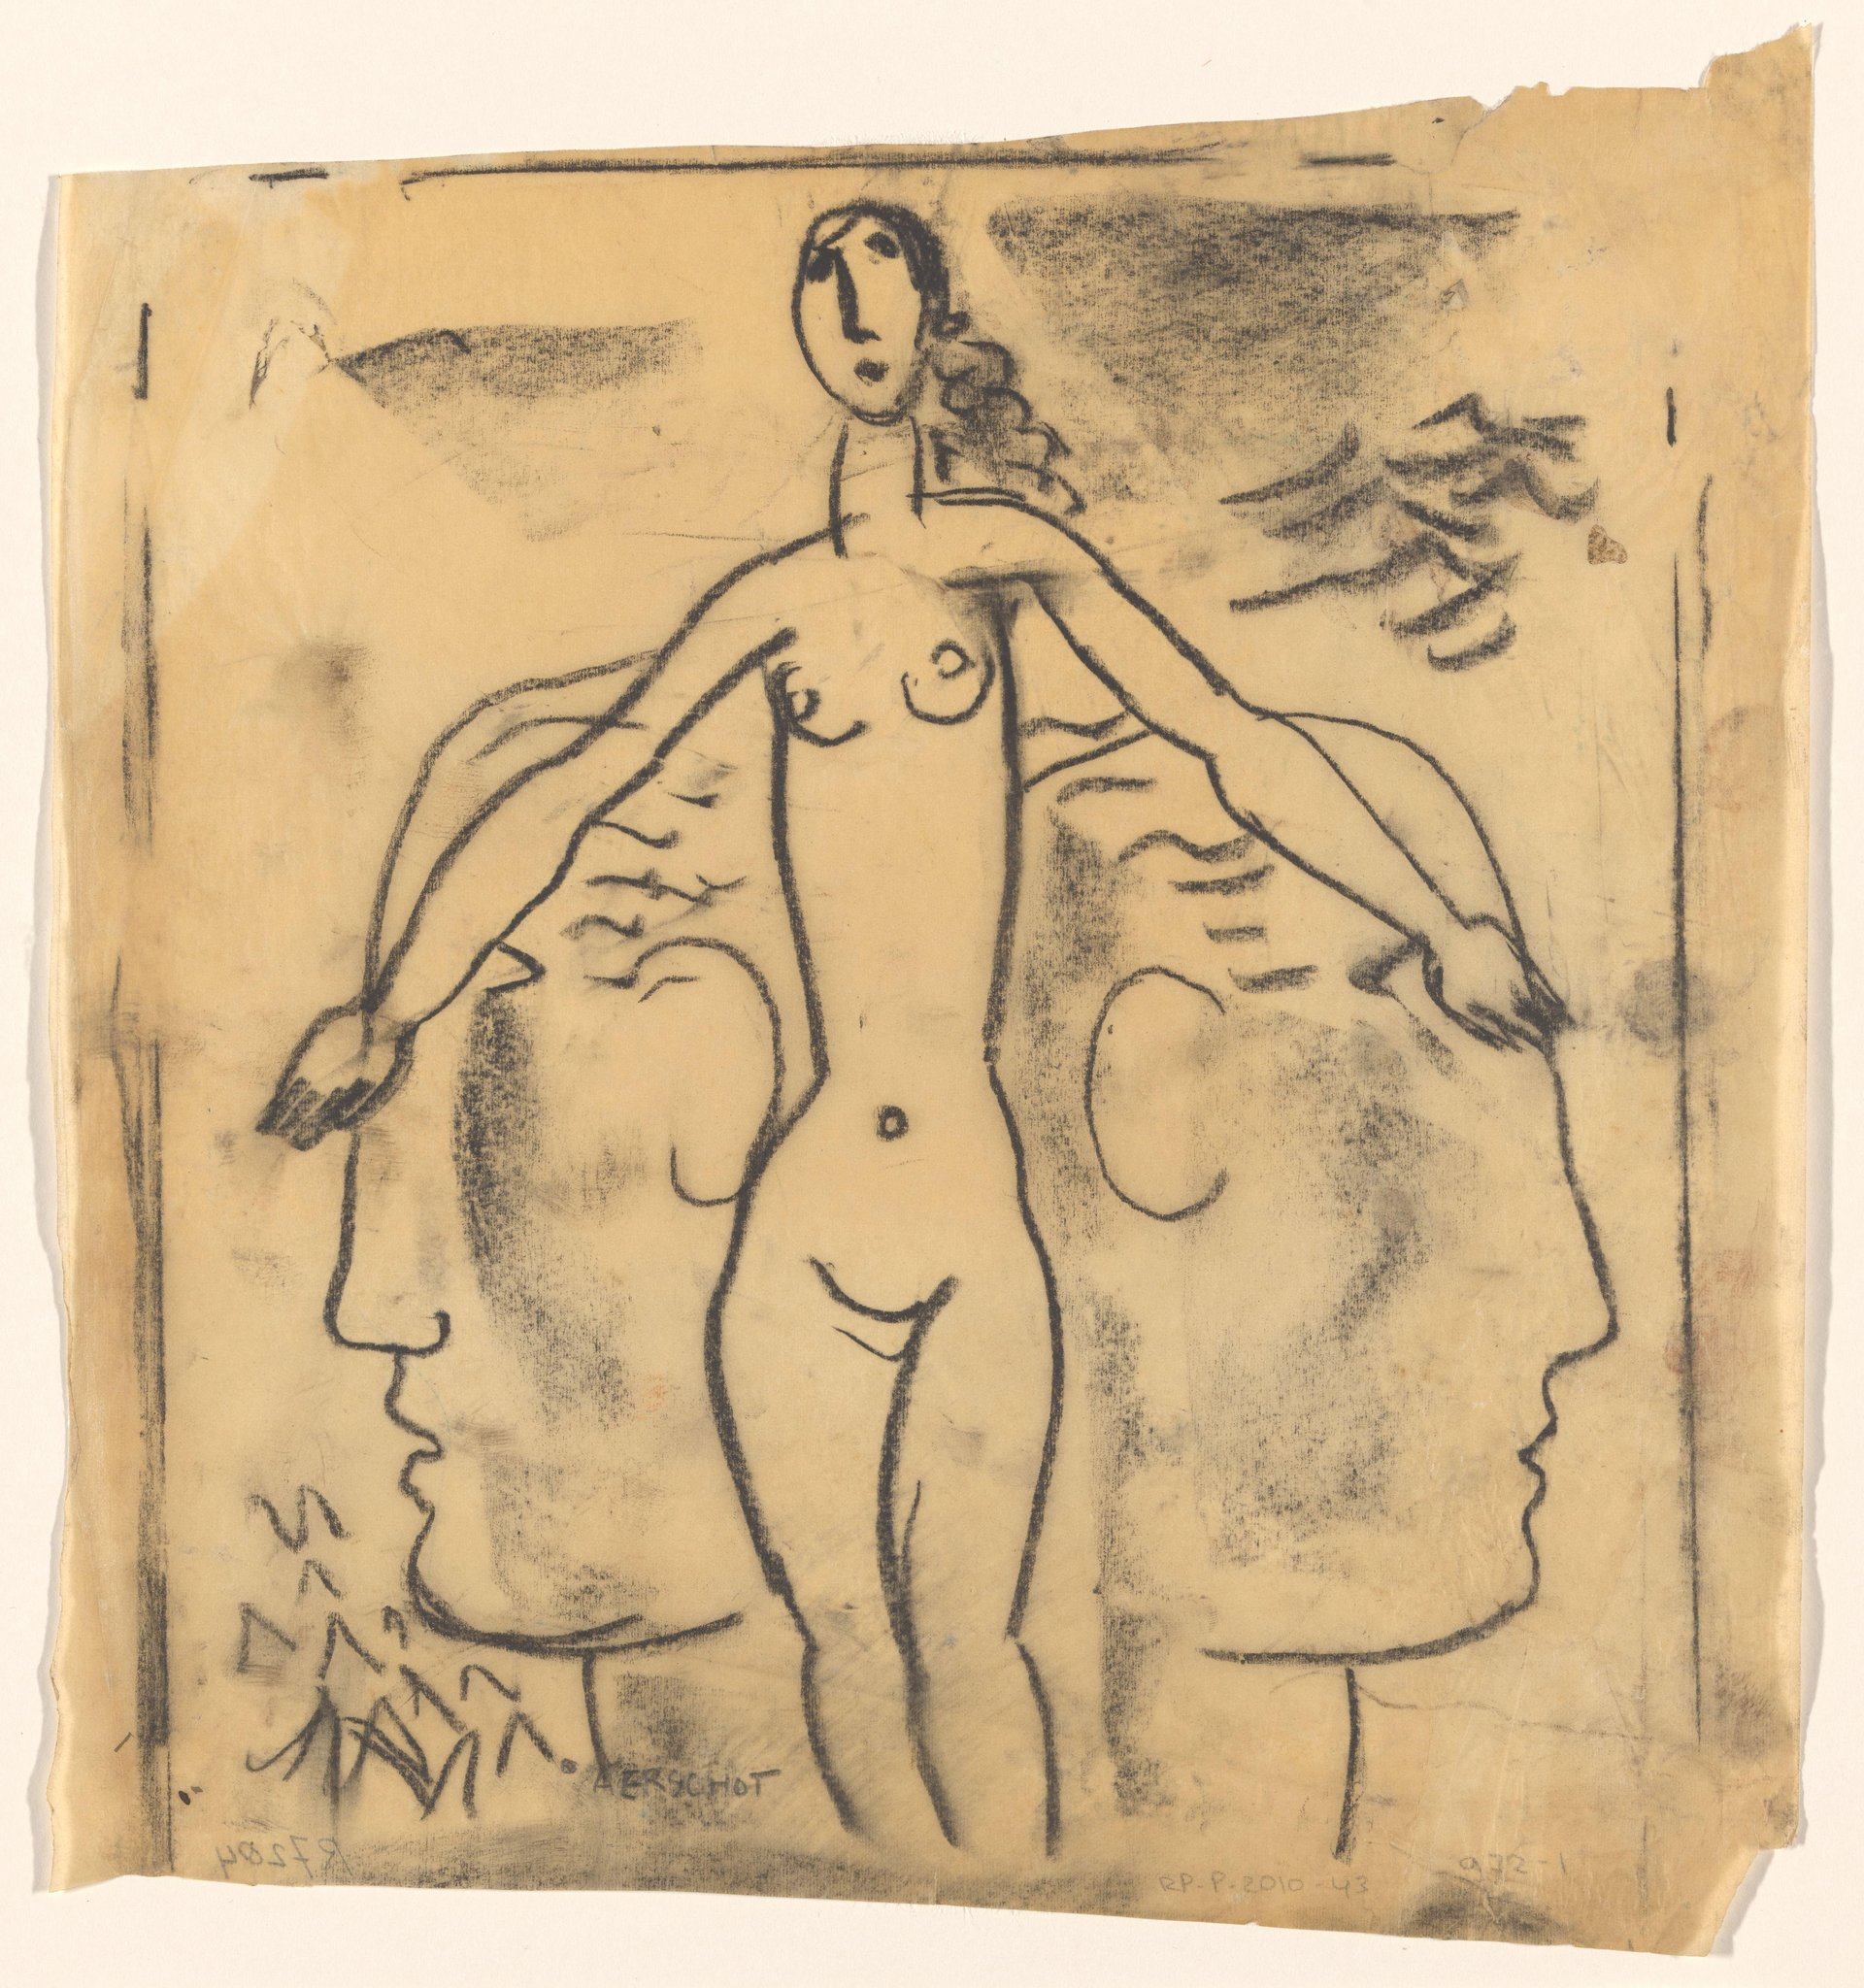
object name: study for binding design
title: Vrouwelijk naakt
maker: leo gestel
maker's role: draughtsman, print maker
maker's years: 1881-1941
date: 1933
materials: chalk, paper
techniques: drawing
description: Vrouwelijk naakt tussen twee gezichten en profil; ontwerp voor boekomslag Paul Fierens 'L'Art Hollandais contemporain'.